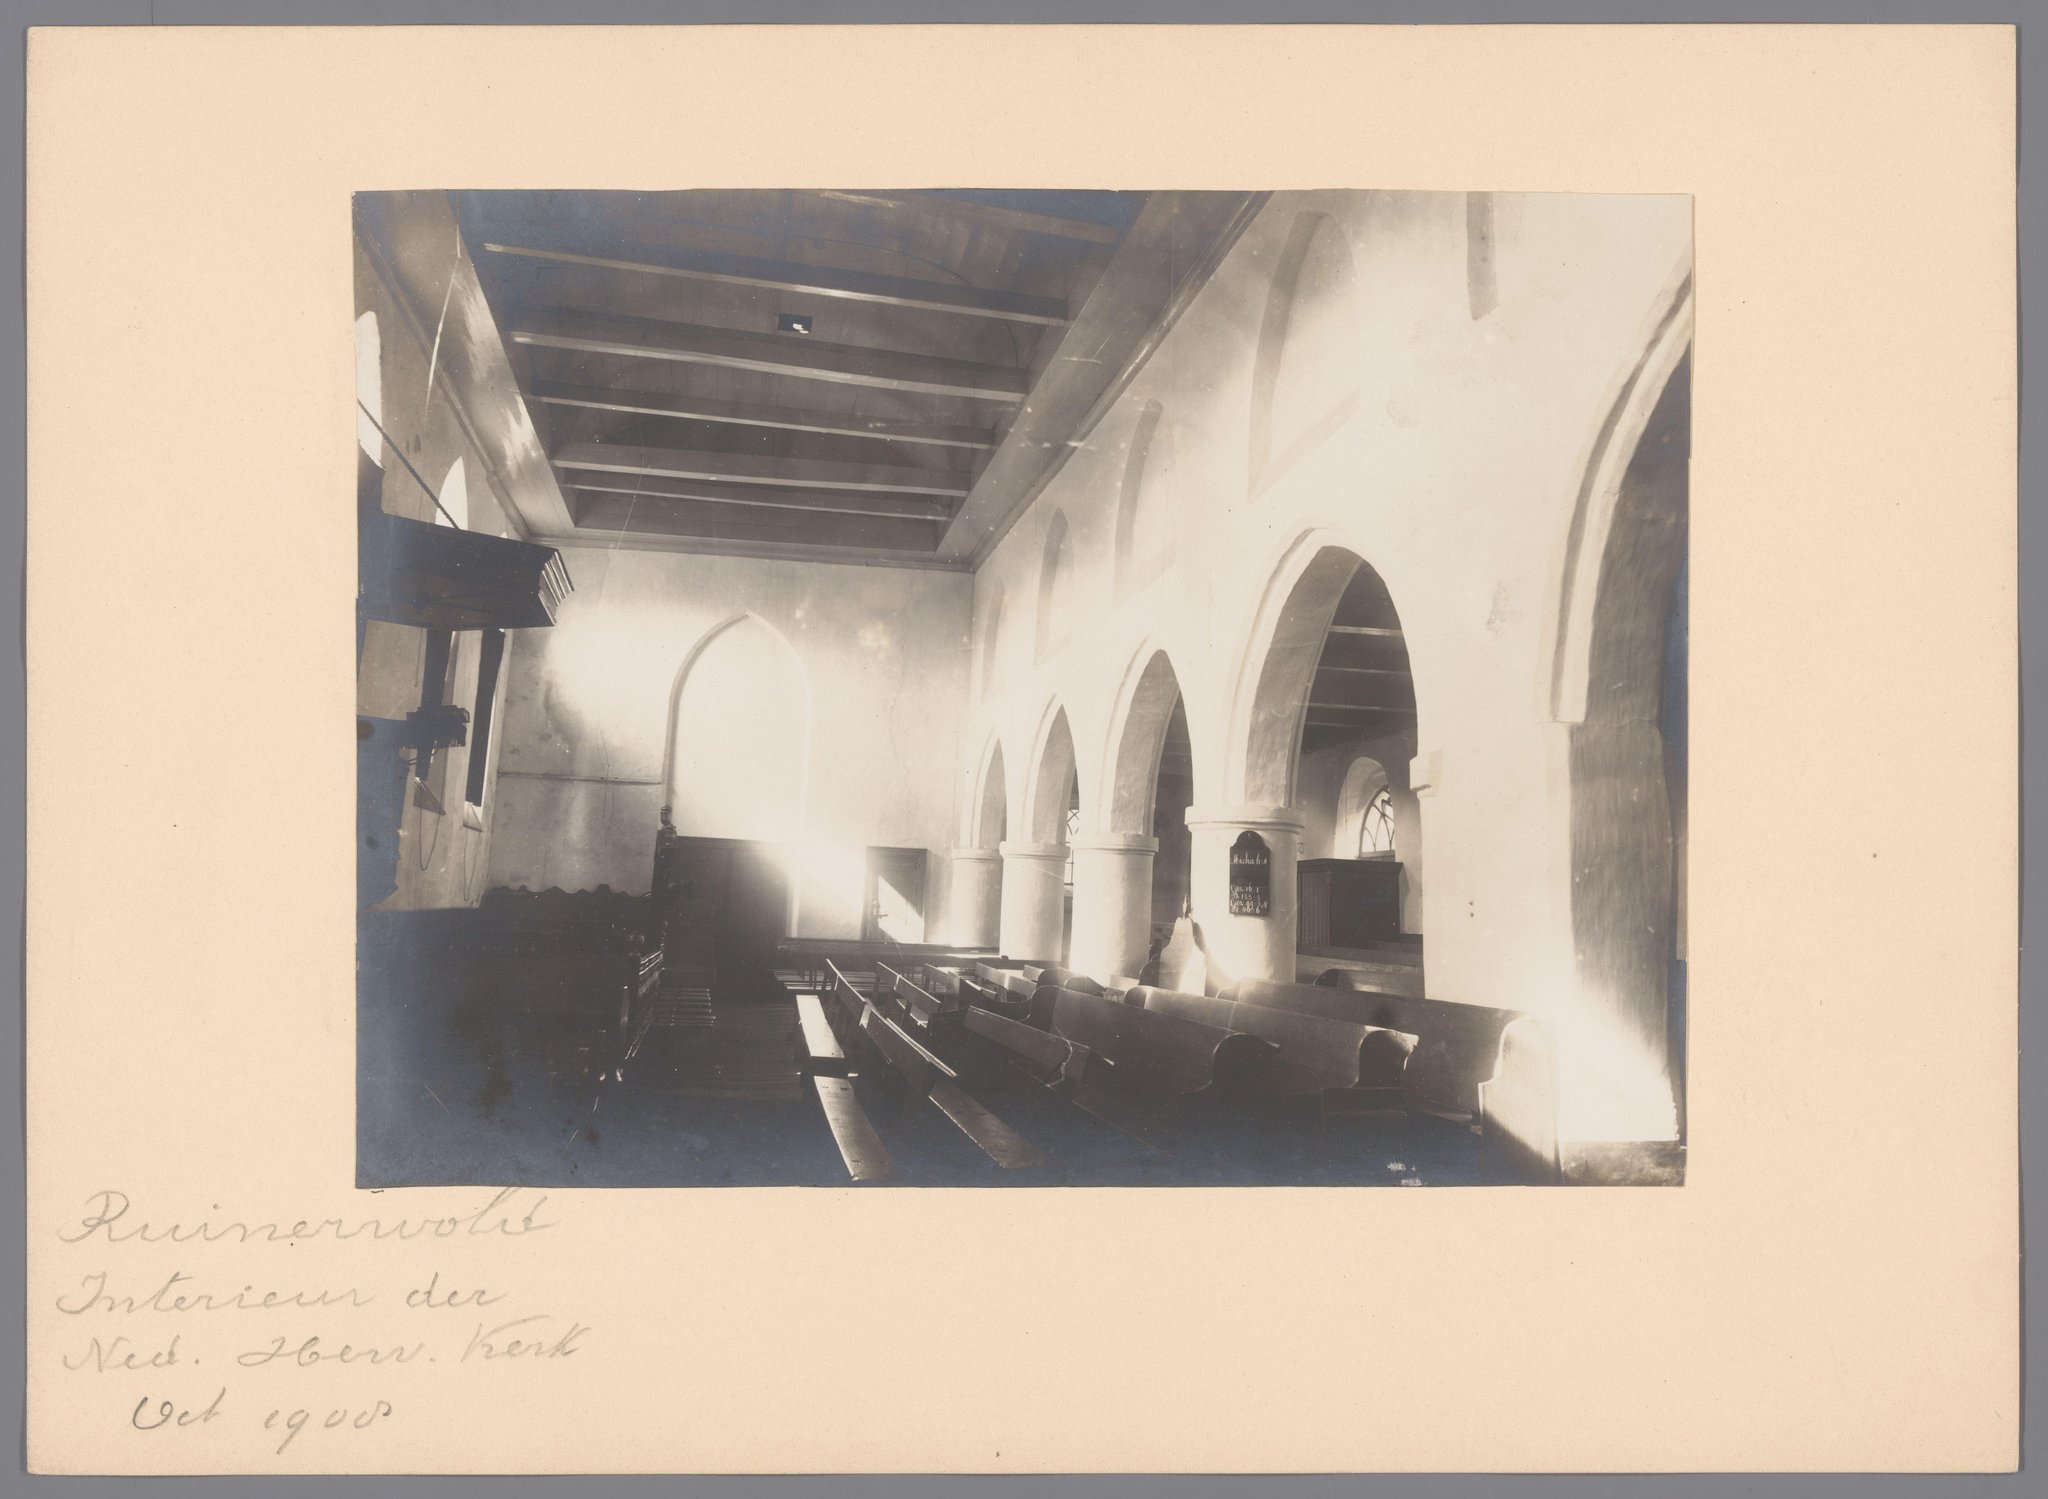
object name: photograph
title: Interieur van de Hervormde Kerk te Ruinerwold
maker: anoniem (monumentenzorg)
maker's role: fotograaf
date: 1908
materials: cardboard, photographic support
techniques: gelatin silver print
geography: ruinerwold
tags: interior of church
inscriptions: annotation: ‘Kerk v/d N.H. gemeente te Peize (?)/ (Drenthe)/ Aug 1898’, annotation: ‘Ruinerwold/ Interieur der Ned. Herv. Kerk/ Oct 1908’